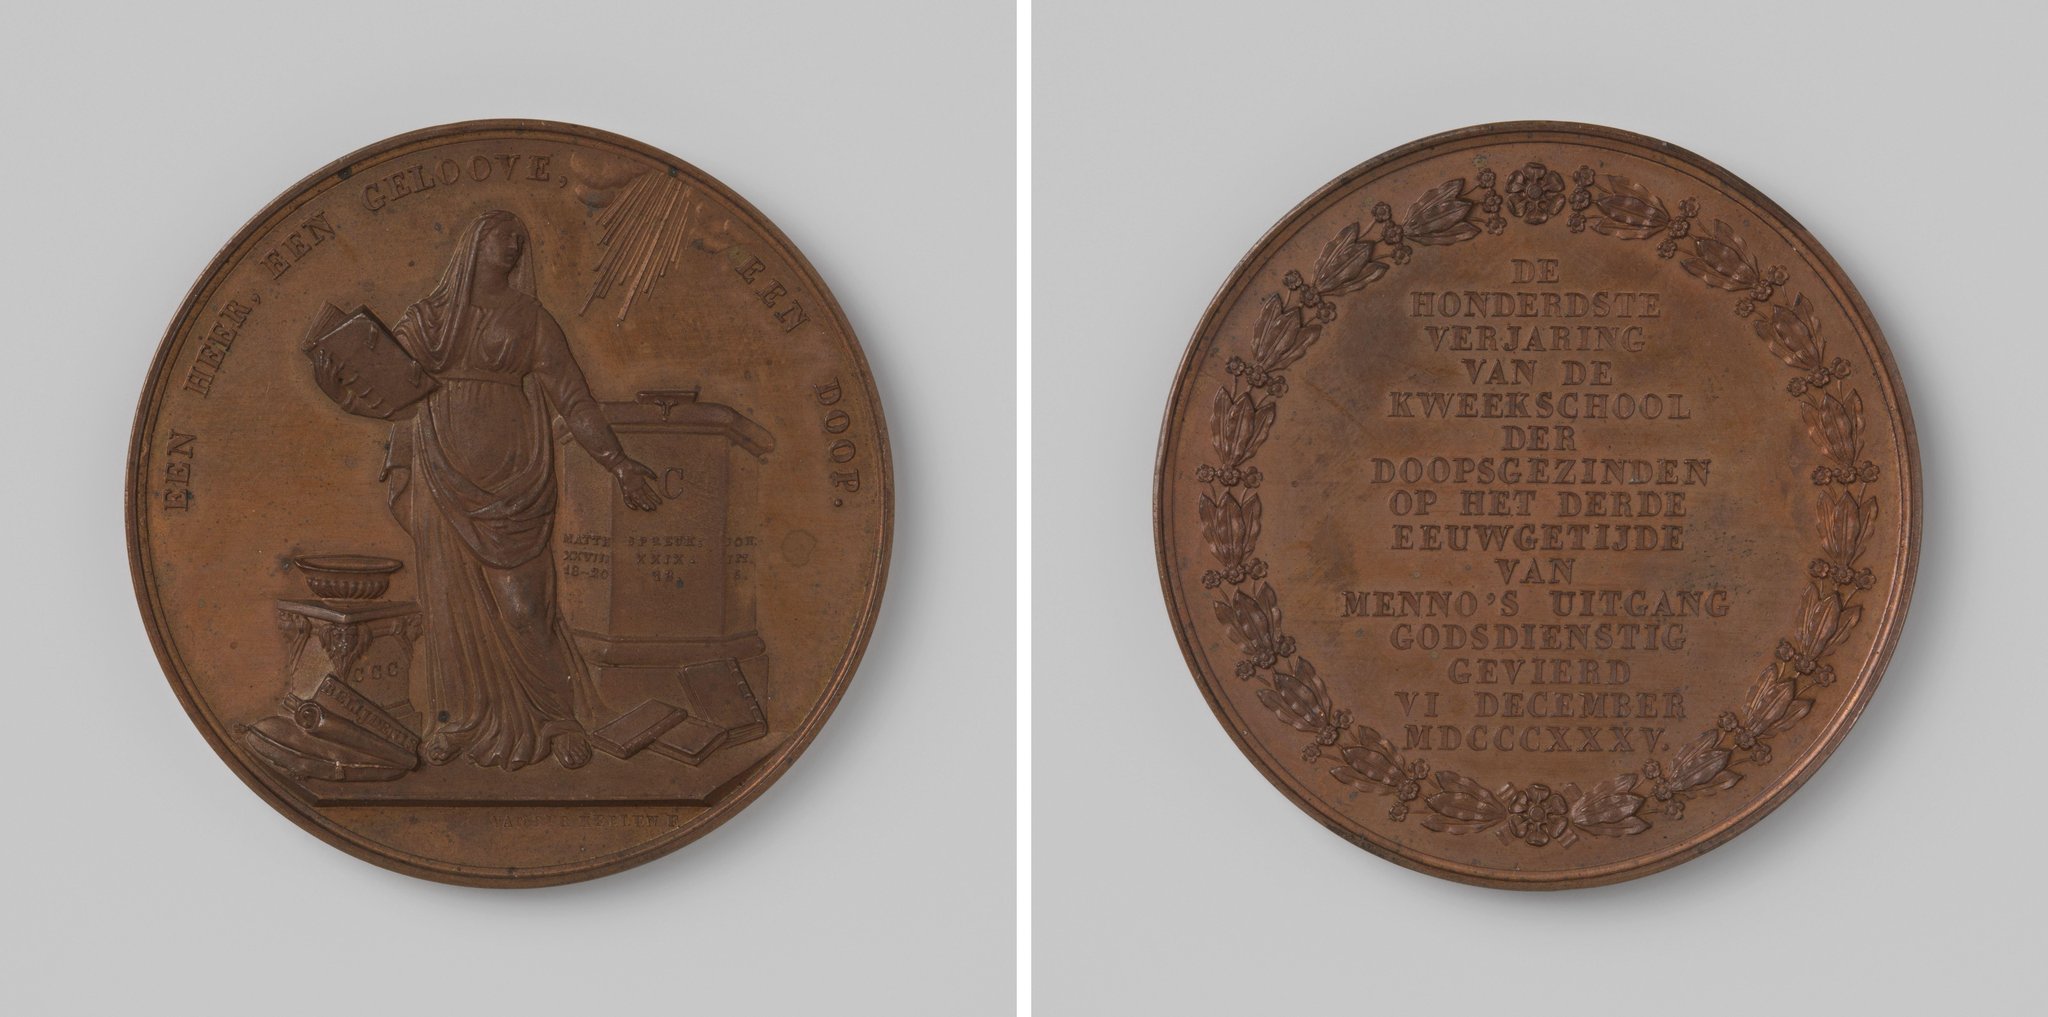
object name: history medal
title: Honderdjarig bestaan van de kweekschool der Doopsgezinden te Amsterdam en driehonderjarige herdenking van het uittreden van Menno Symonsz.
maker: david van der kellen (1804-1879)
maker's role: die cutter, draughtsman, print maker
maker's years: 1804-1879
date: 1835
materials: bronze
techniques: striking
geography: utrecht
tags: clergyman, amsterdam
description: Bronzen penning. Voorzijde: beschenen door hemellicht staat gesluierde vrouw met open boek in hand,voorstellende Godsdienst tussen catheder, waarvoor drie boeken liggen en doopvont,waartegen voor helft ontrold geschrift ligt binnen omschrift; afsnede: signatuur. Keerzijde: opschrift binnen krans van myrteloof